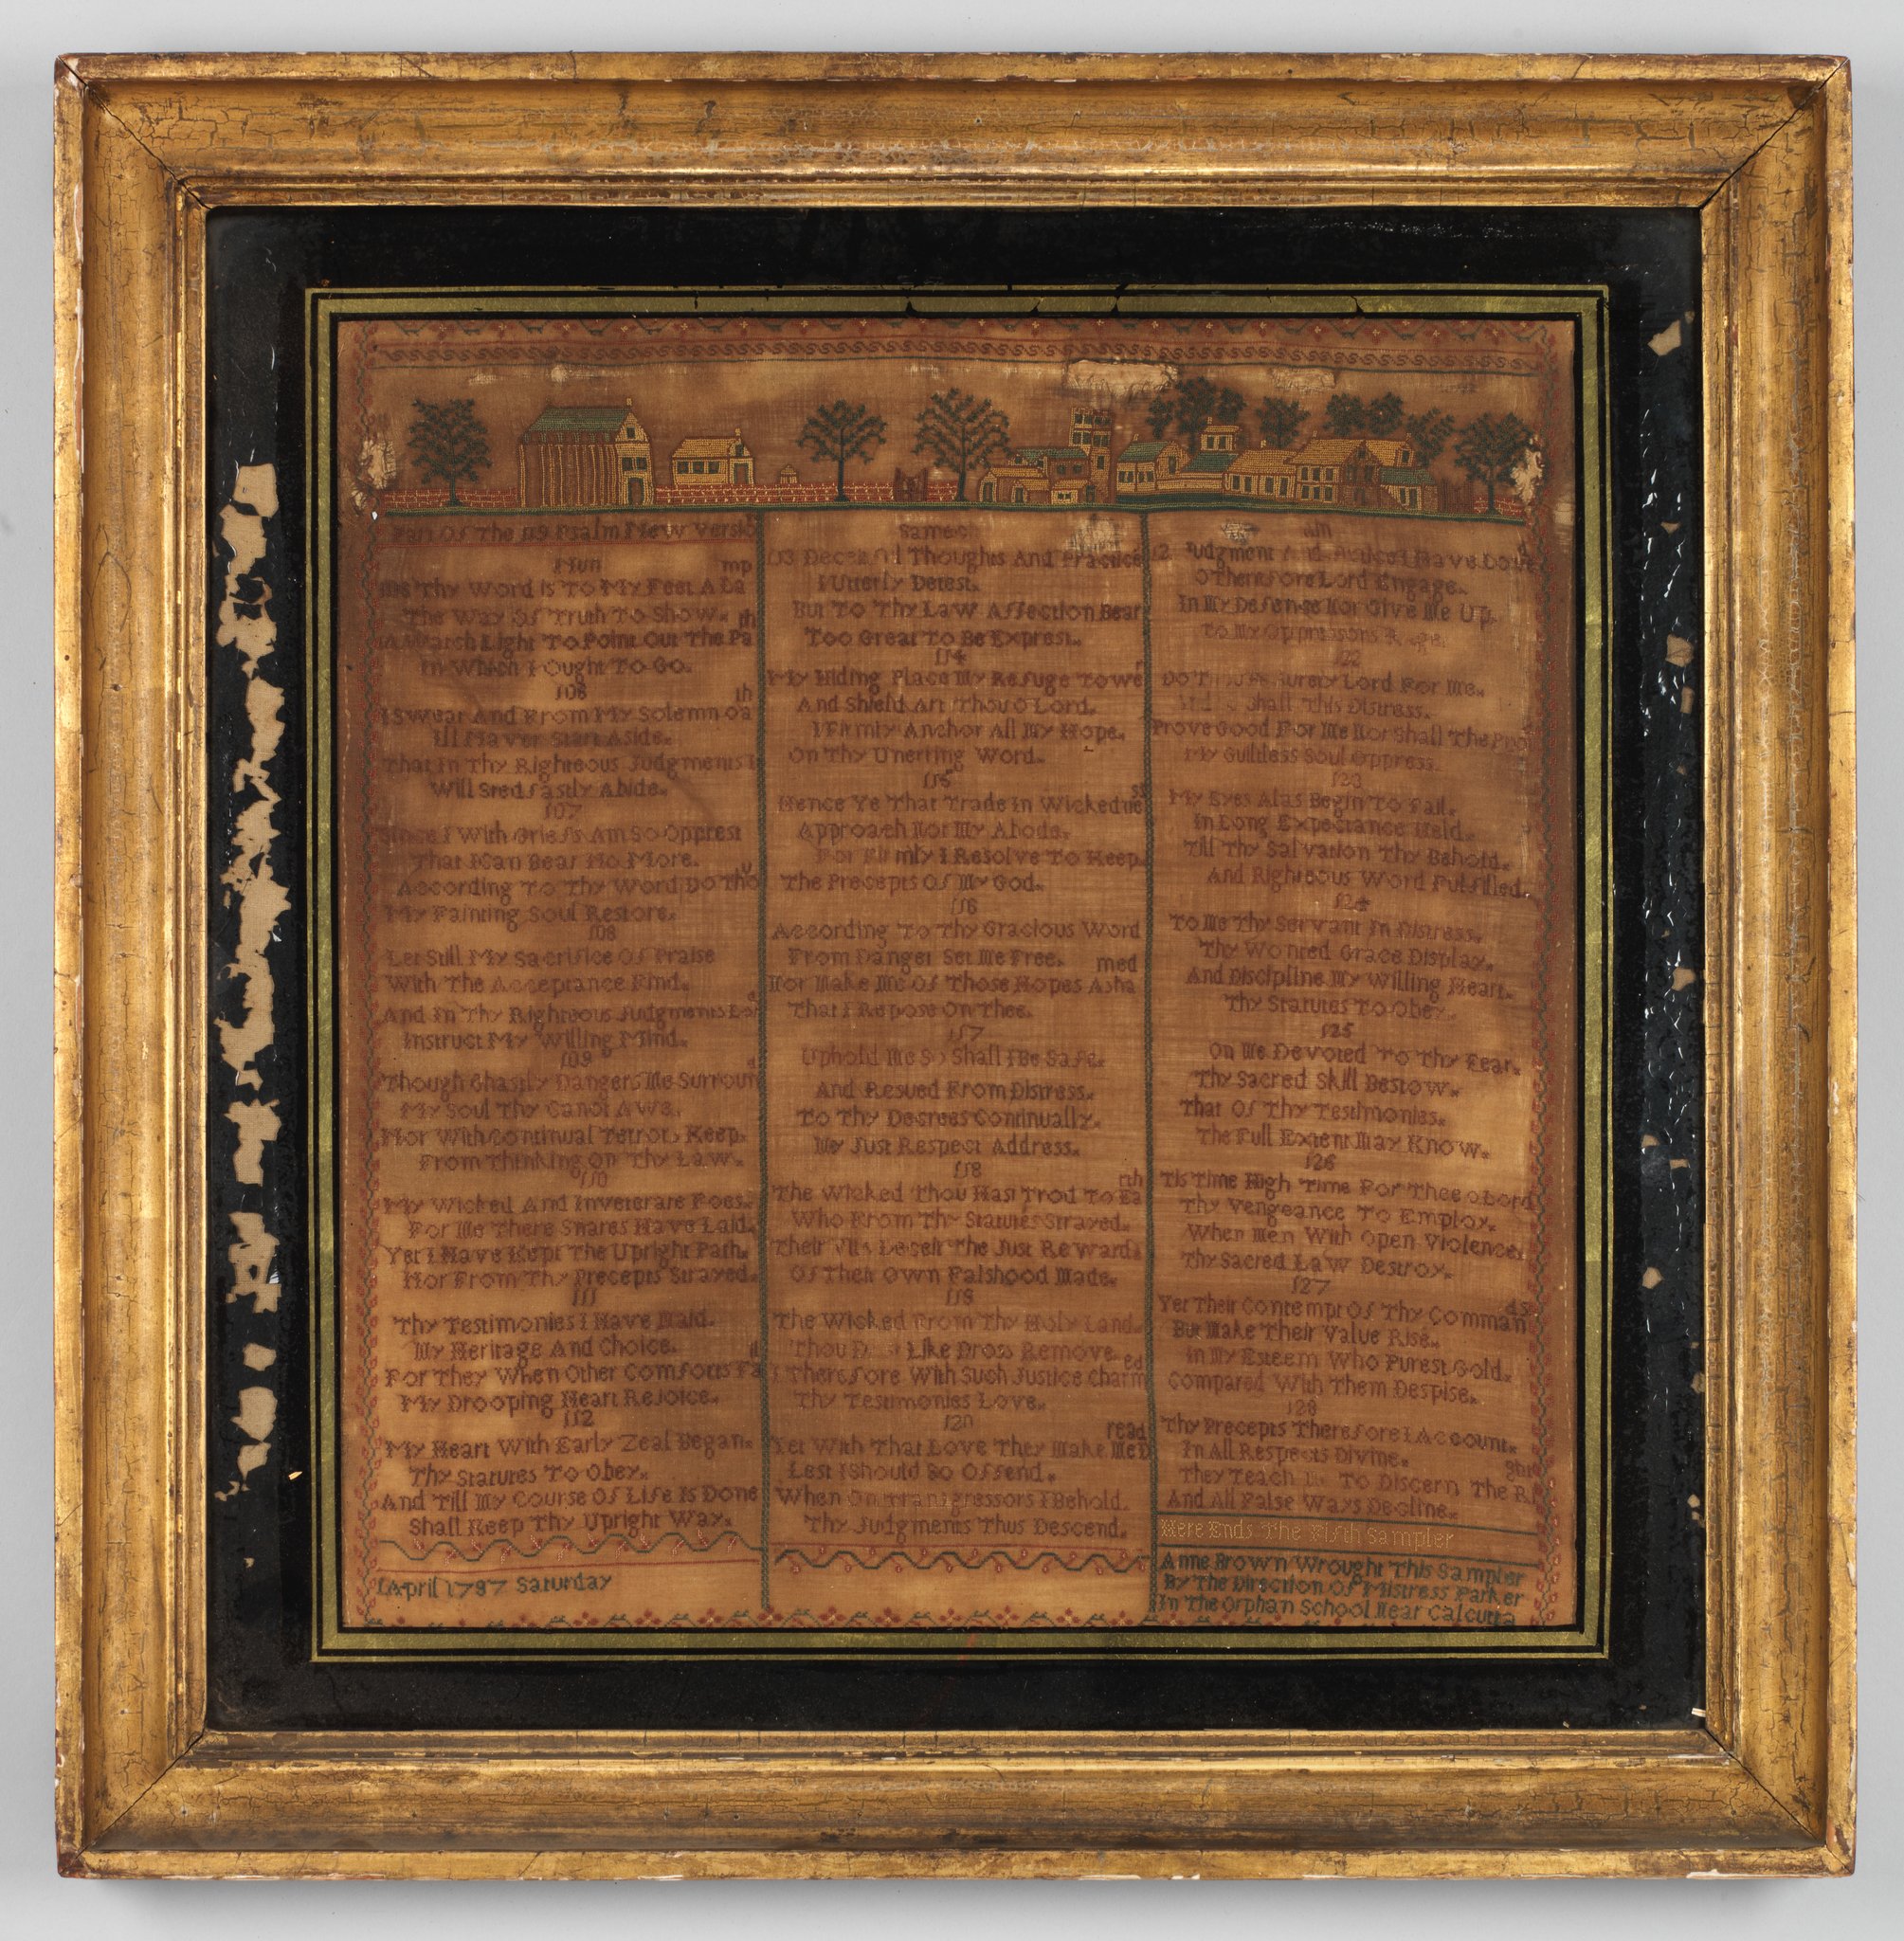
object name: sampler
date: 1797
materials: cotton, silk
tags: houses,trees